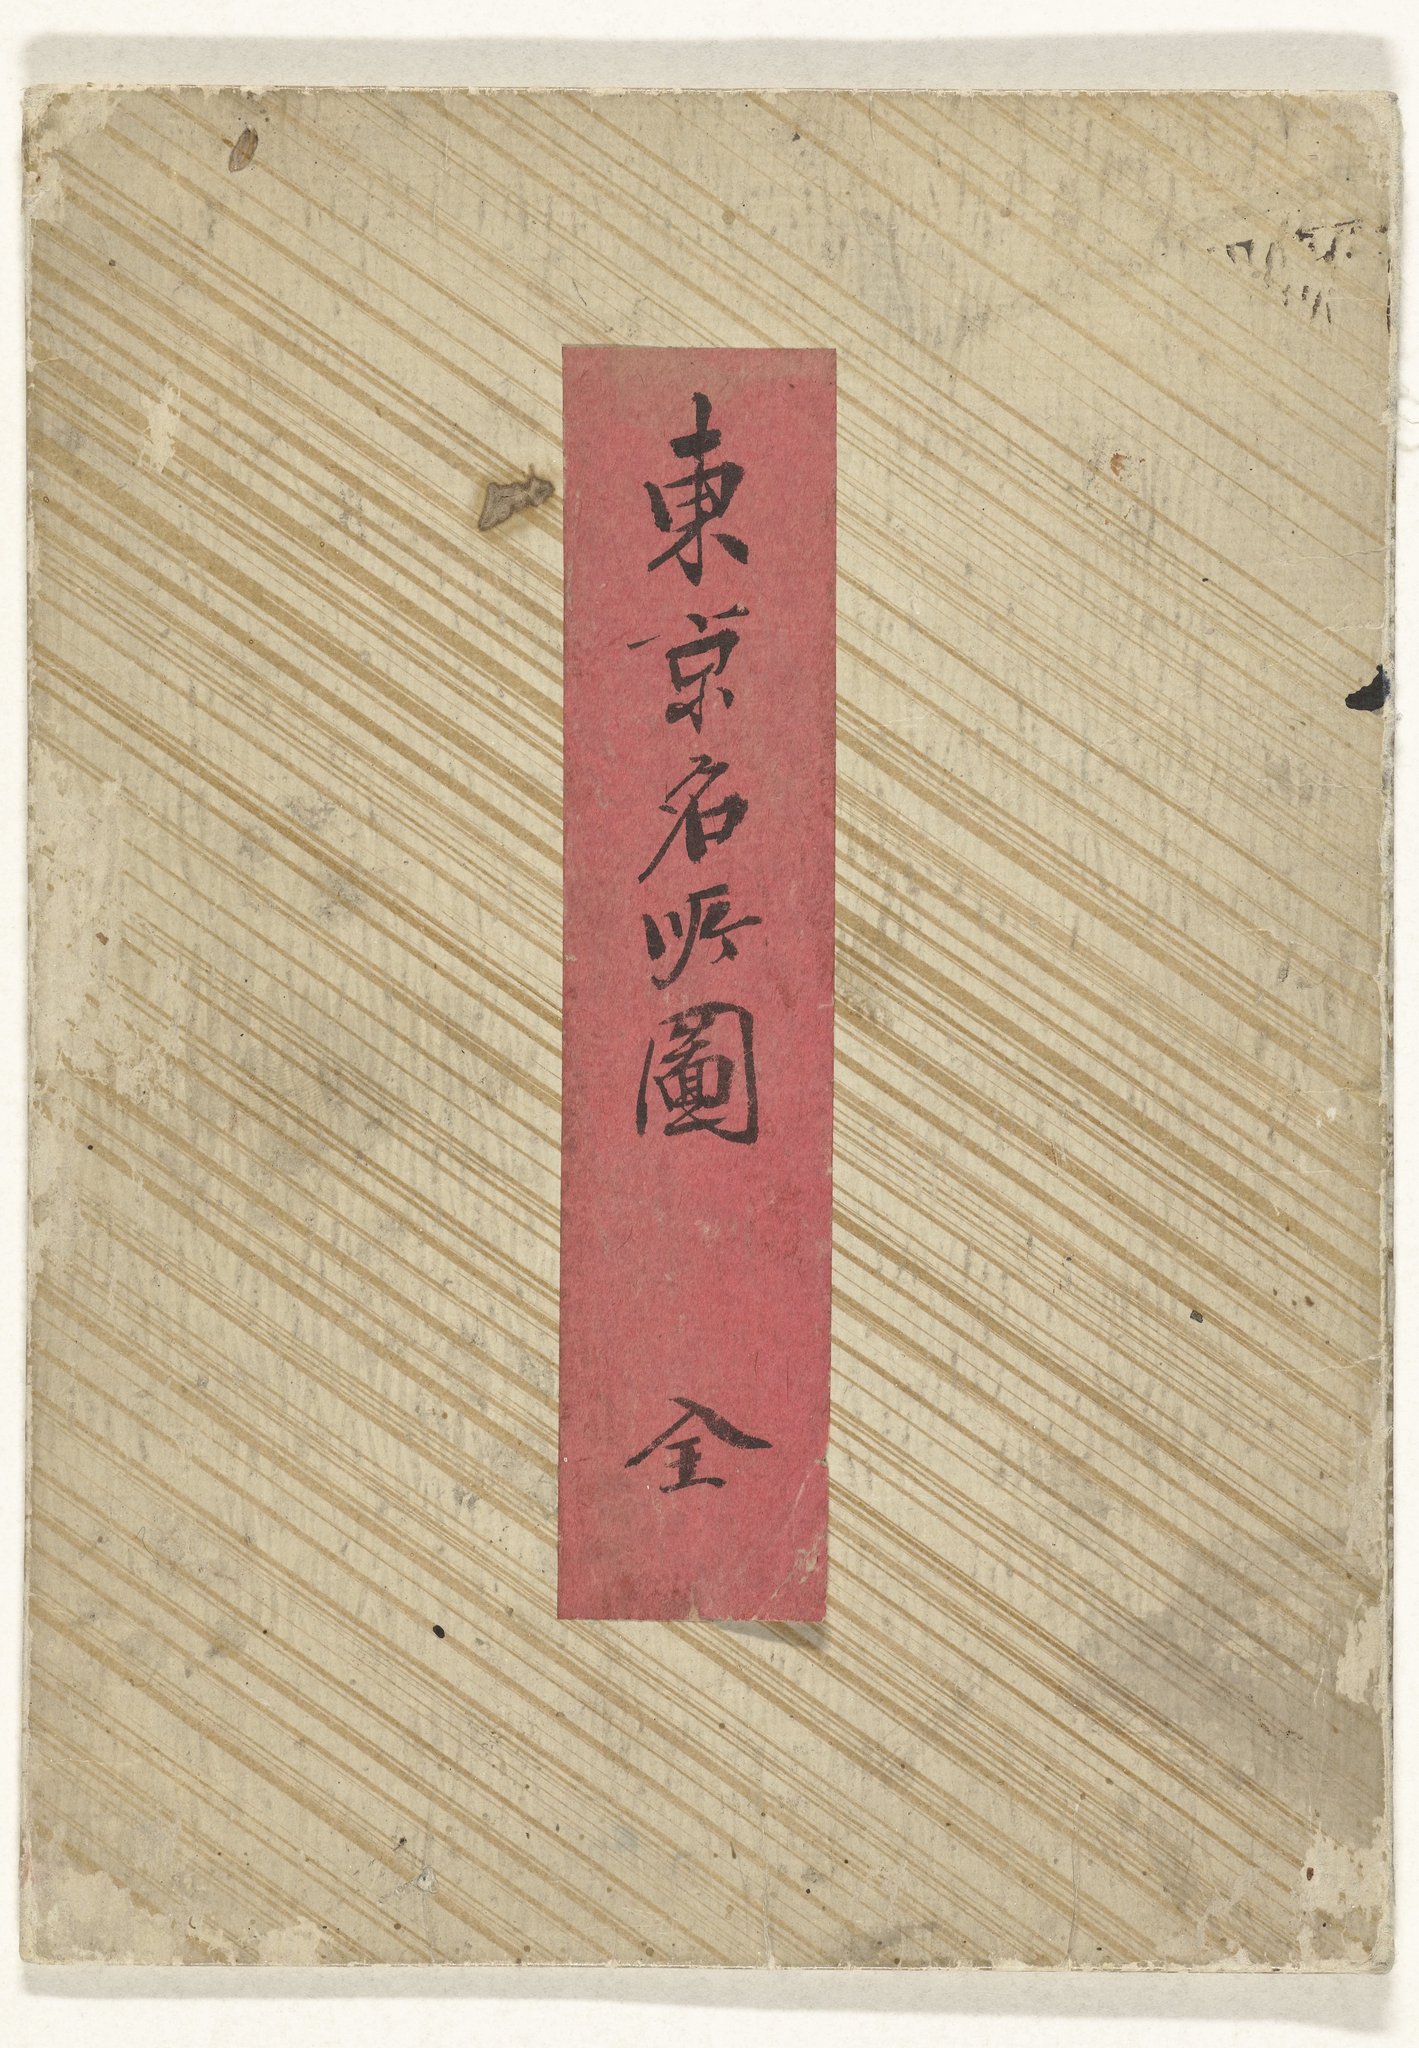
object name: kaft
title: Afbeeldingen van beroemde plaatsen in Tokyo- compleet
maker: kobayashi kiyochika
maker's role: print maker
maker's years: 1847-1915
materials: cardboard, paper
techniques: woodcut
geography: japan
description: Kaft van een album behorende bij tien prenten van Kobayashi Kiyochika met afbeeldingen uit Tokyo en omgeving.